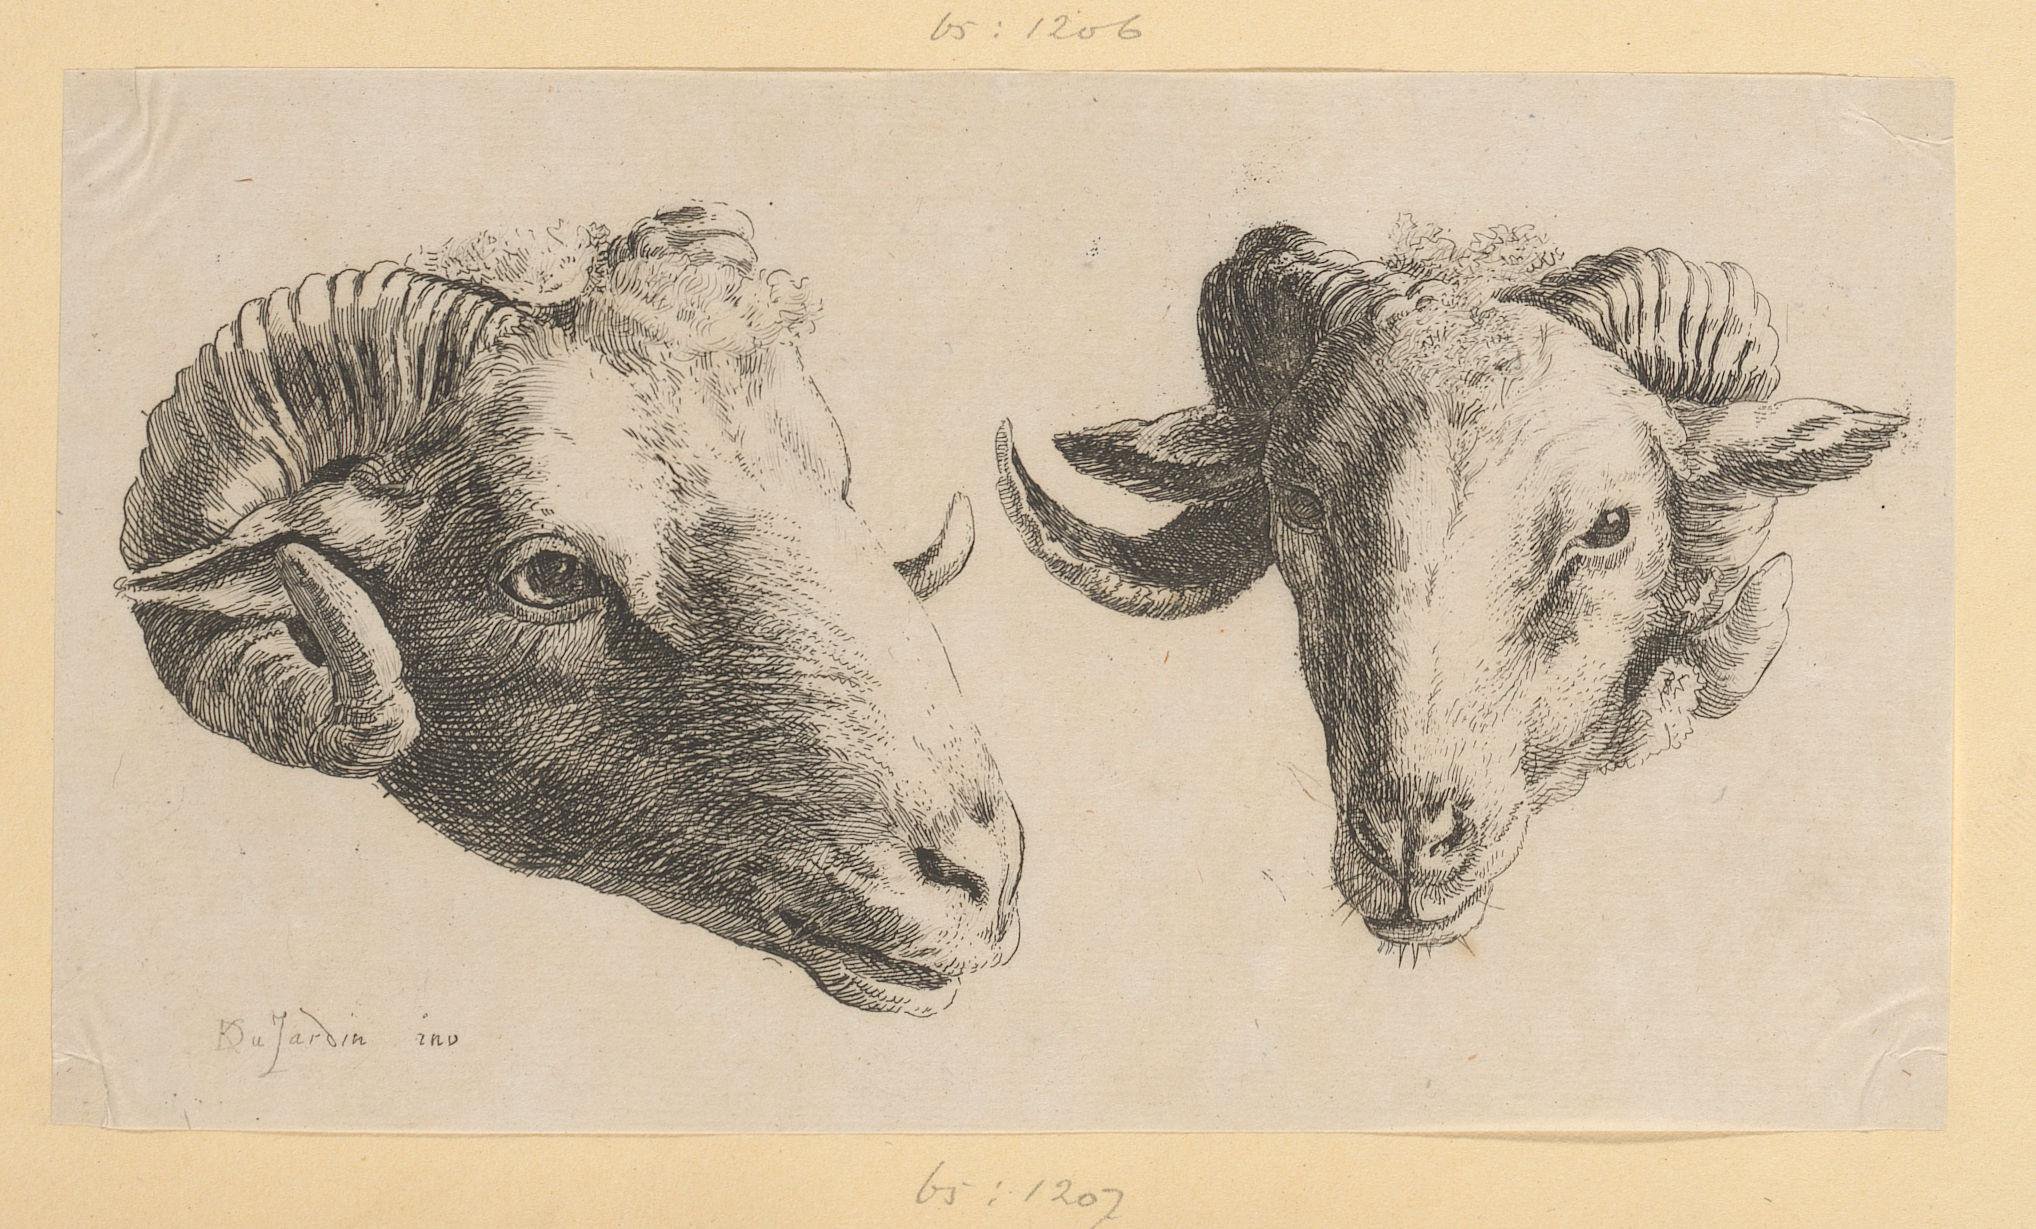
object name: album leaf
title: Twee ramskoppen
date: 1805-1844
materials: paper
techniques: etching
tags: ram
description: Prent maakt deel uit van een serie van 11 prenten. Prent maakt mogelijk deel uit van een serie van 200 prenten. Deze serie is onder de titel 'A Collection of two hundred original etchings' voor het eerst uitgegeven door J.M. Greery in 1816.